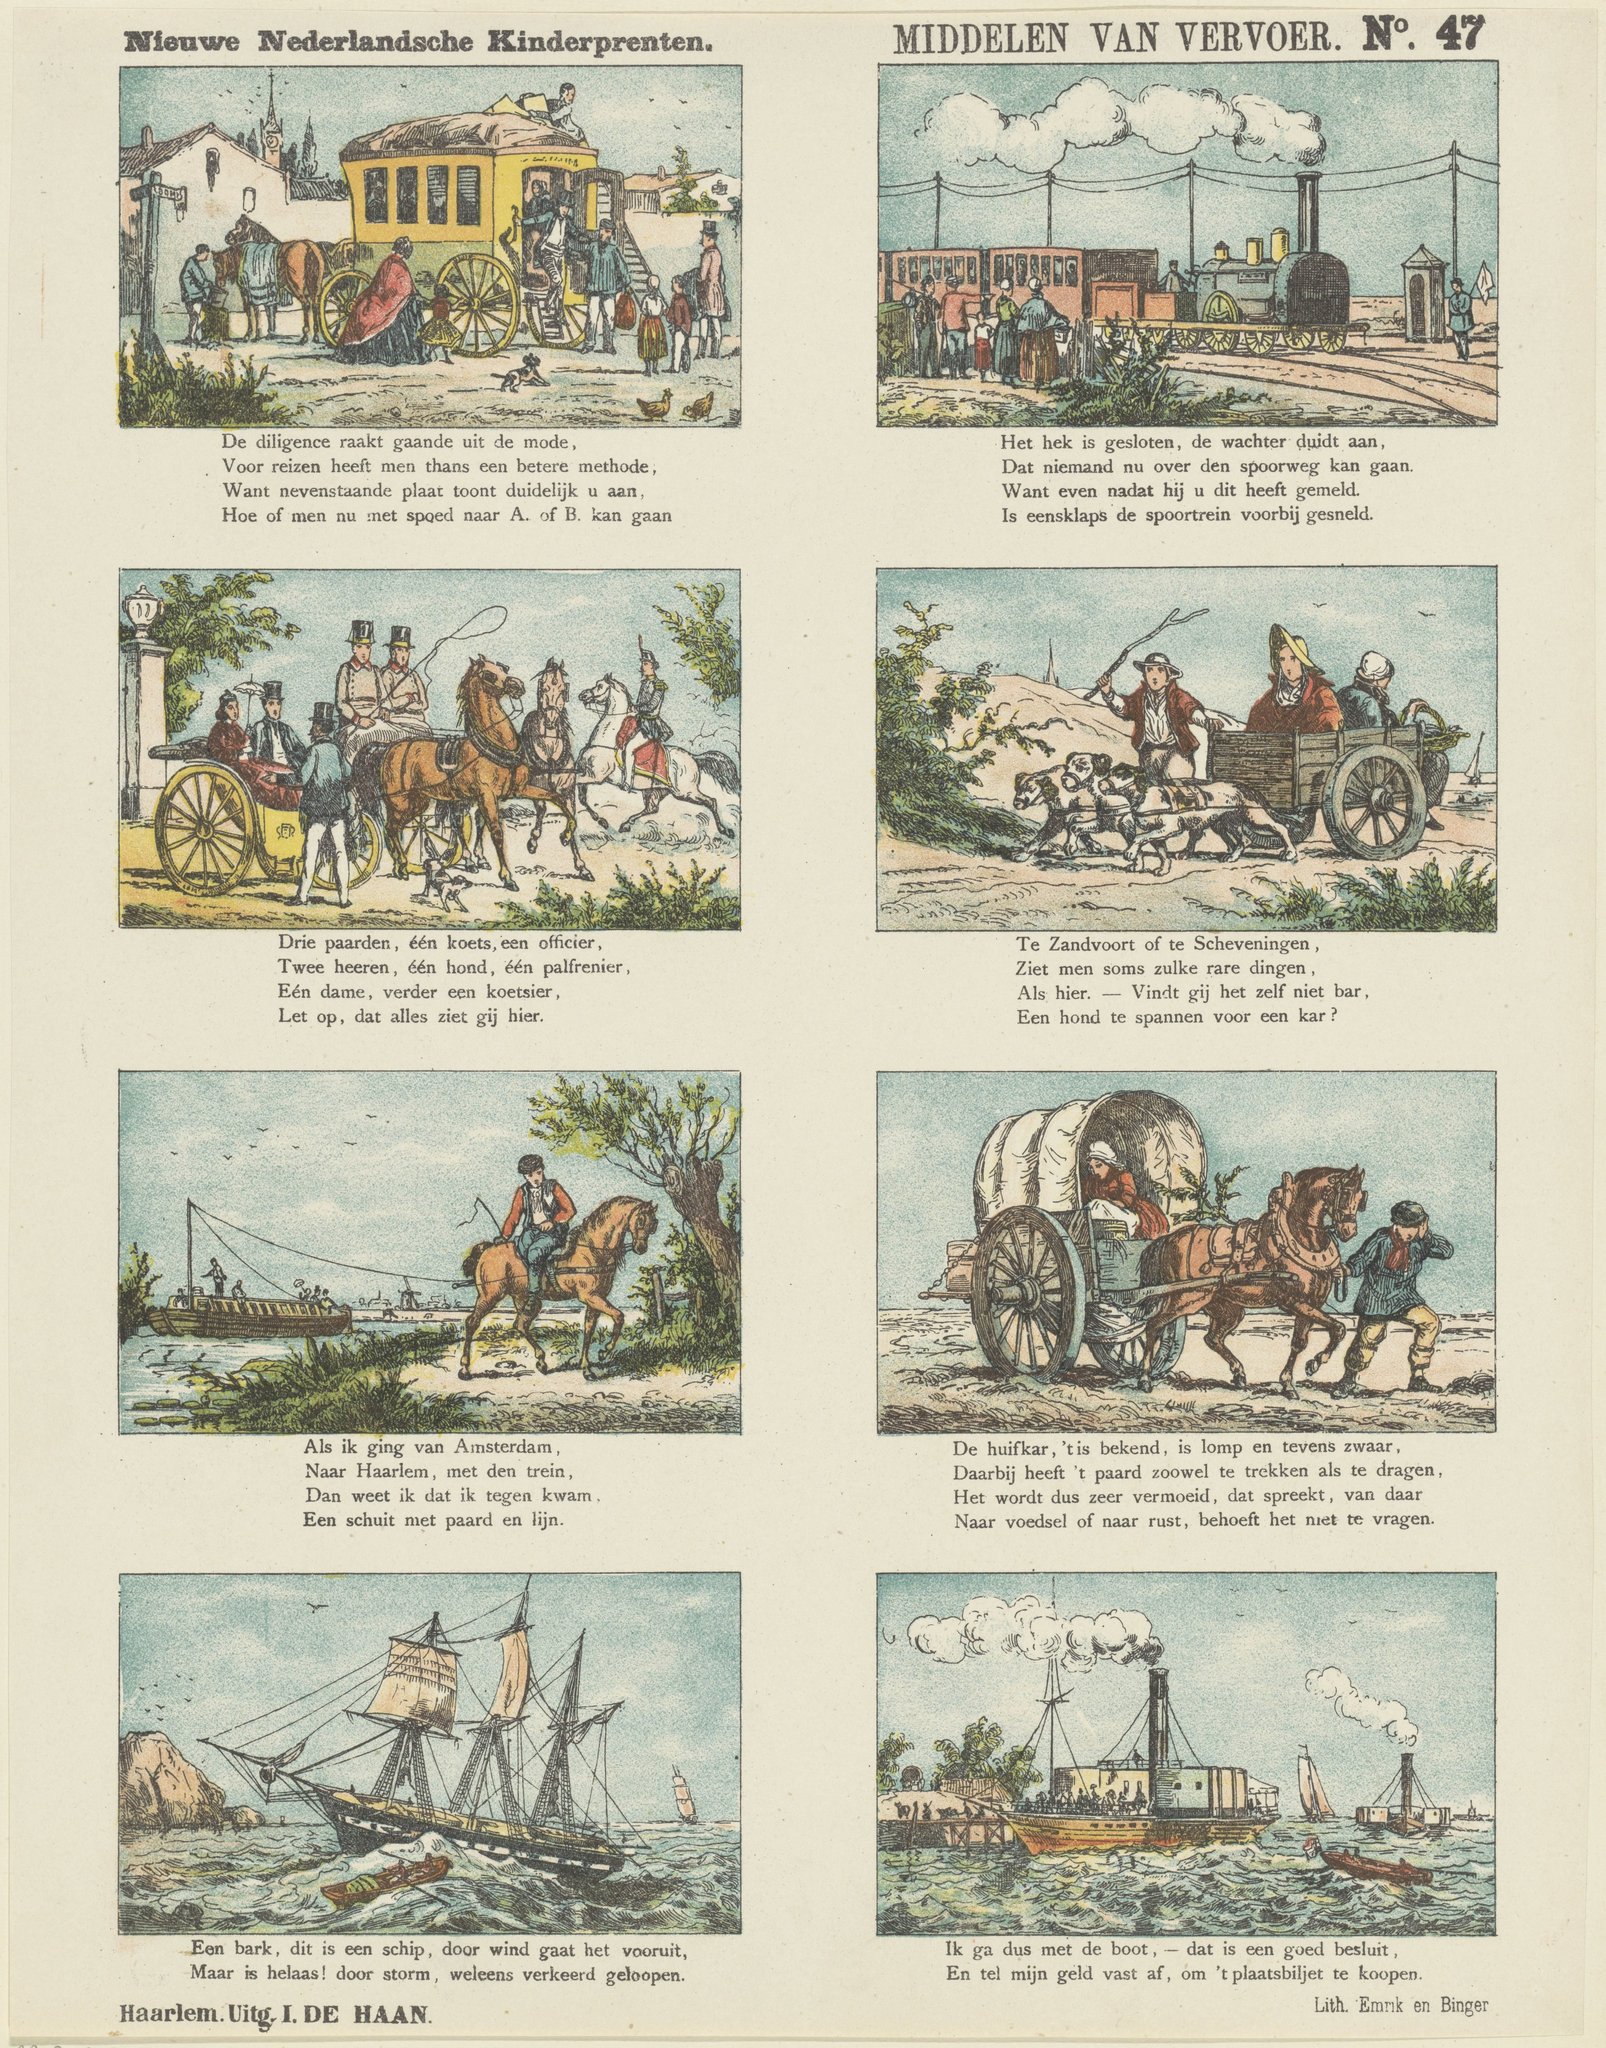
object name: print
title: Middelen van vervoer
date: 1875-1903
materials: paper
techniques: lithograph, letterpress printing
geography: haarlem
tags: diligence, omnibus, horse-tram, traffic and transport, passenger train, ships (in general)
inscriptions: collector's mark: Lugt 2760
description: Blad met 8 voorstellingen van vervoermiddelen, onder andere een diligence of reiskoets, een trekschuit en een stoomboot. Onder elke afbeelding een vers. Genummerd rechtsboven: No. 47.